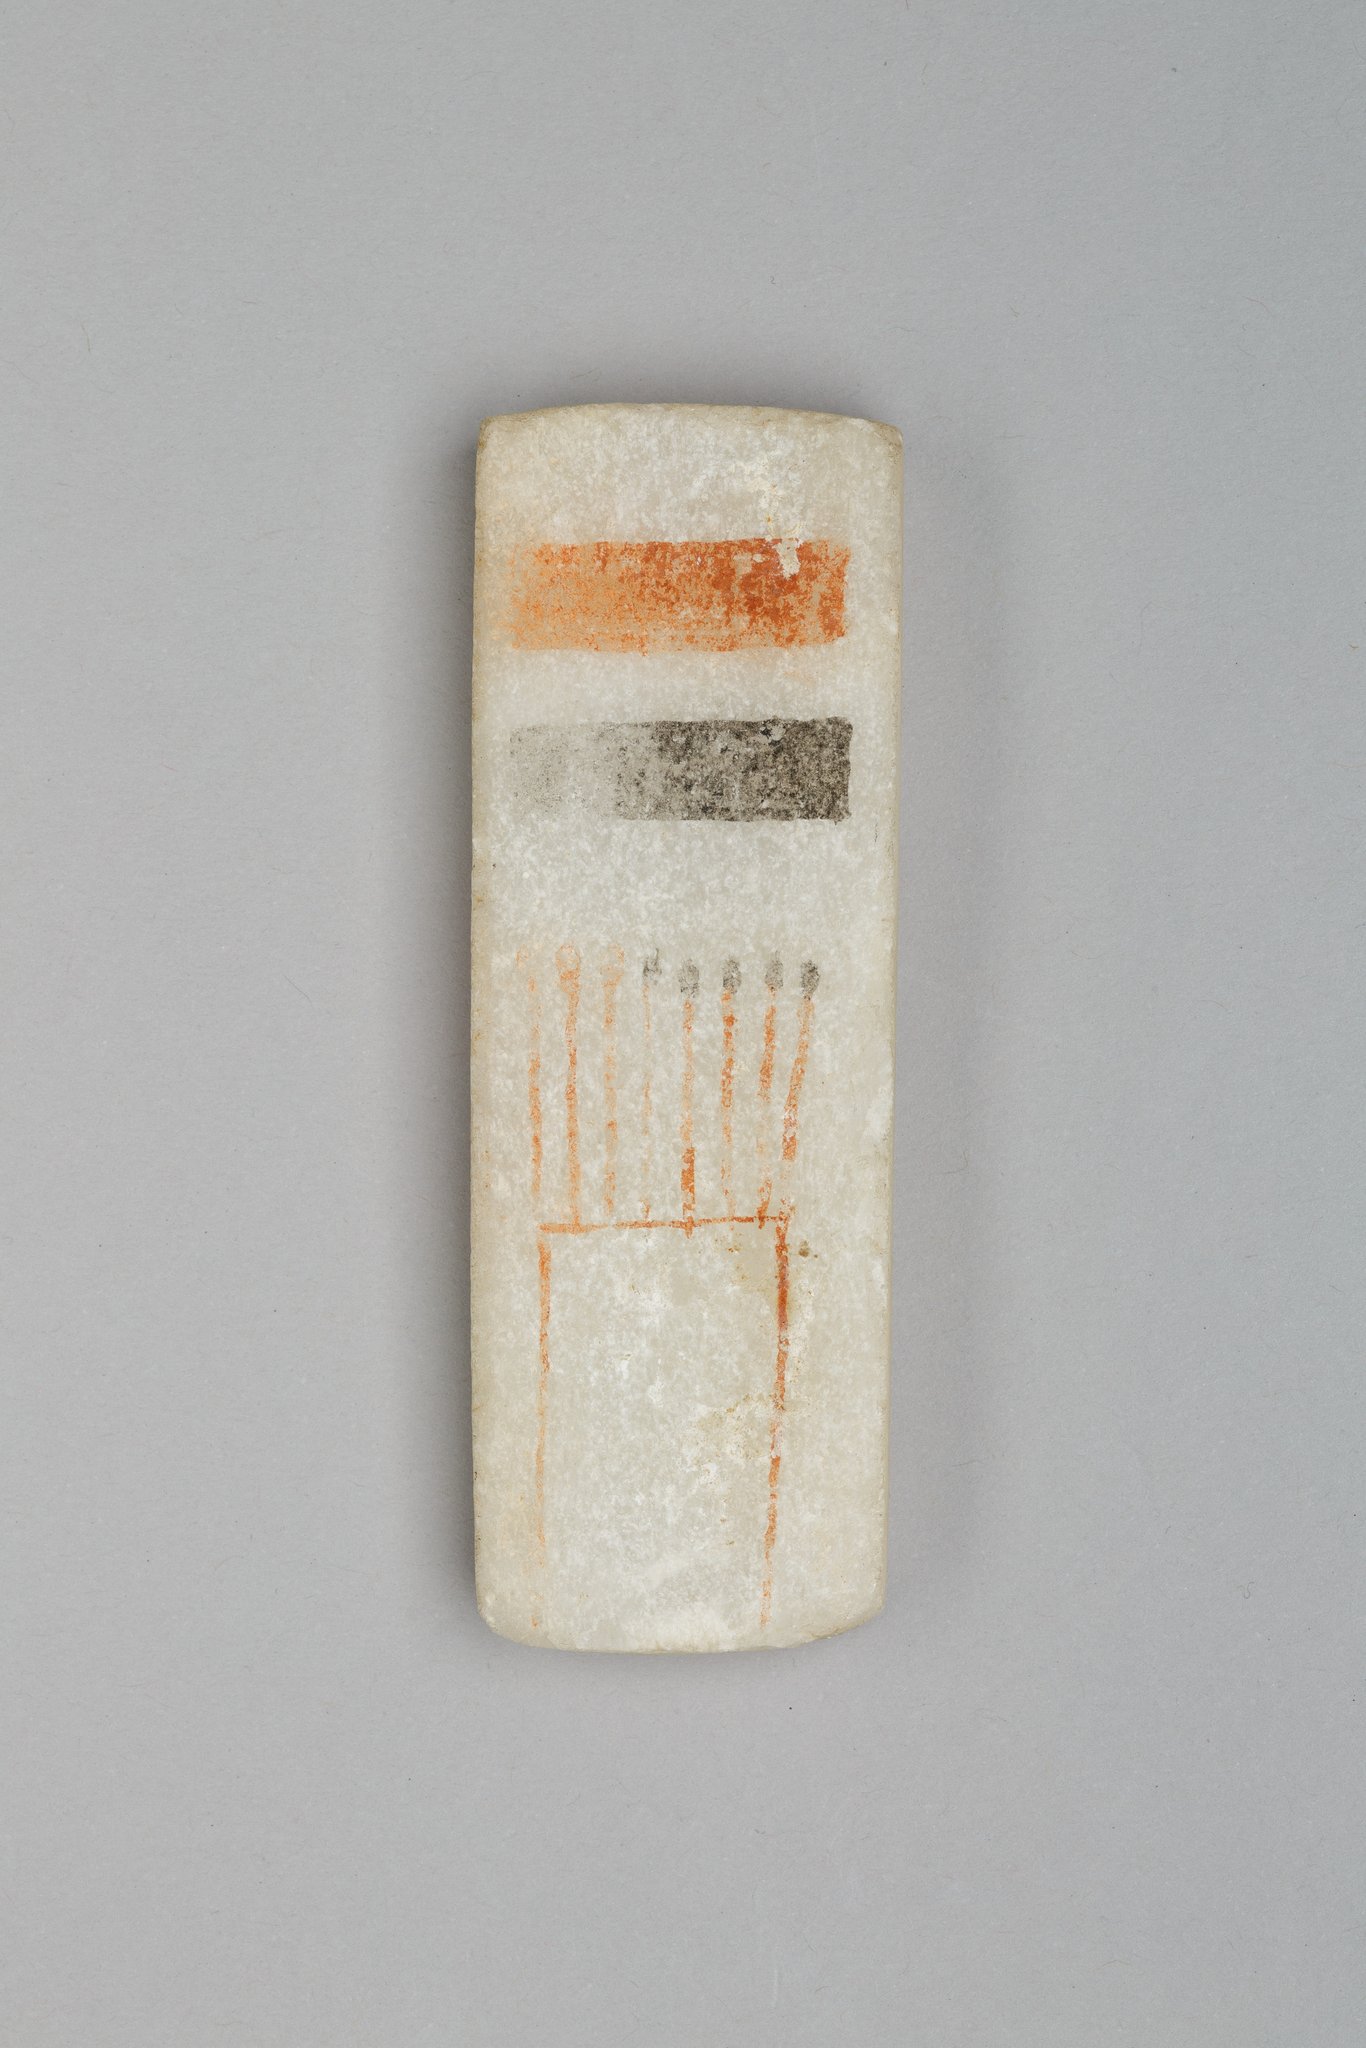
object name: plaque, ramesses iv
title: Plaque painted with names of Ramesses IV on one side and as a scribal palette on the other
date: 1153-1147 BCE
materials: stone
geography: egypt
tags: cartouches,hieroglyphs